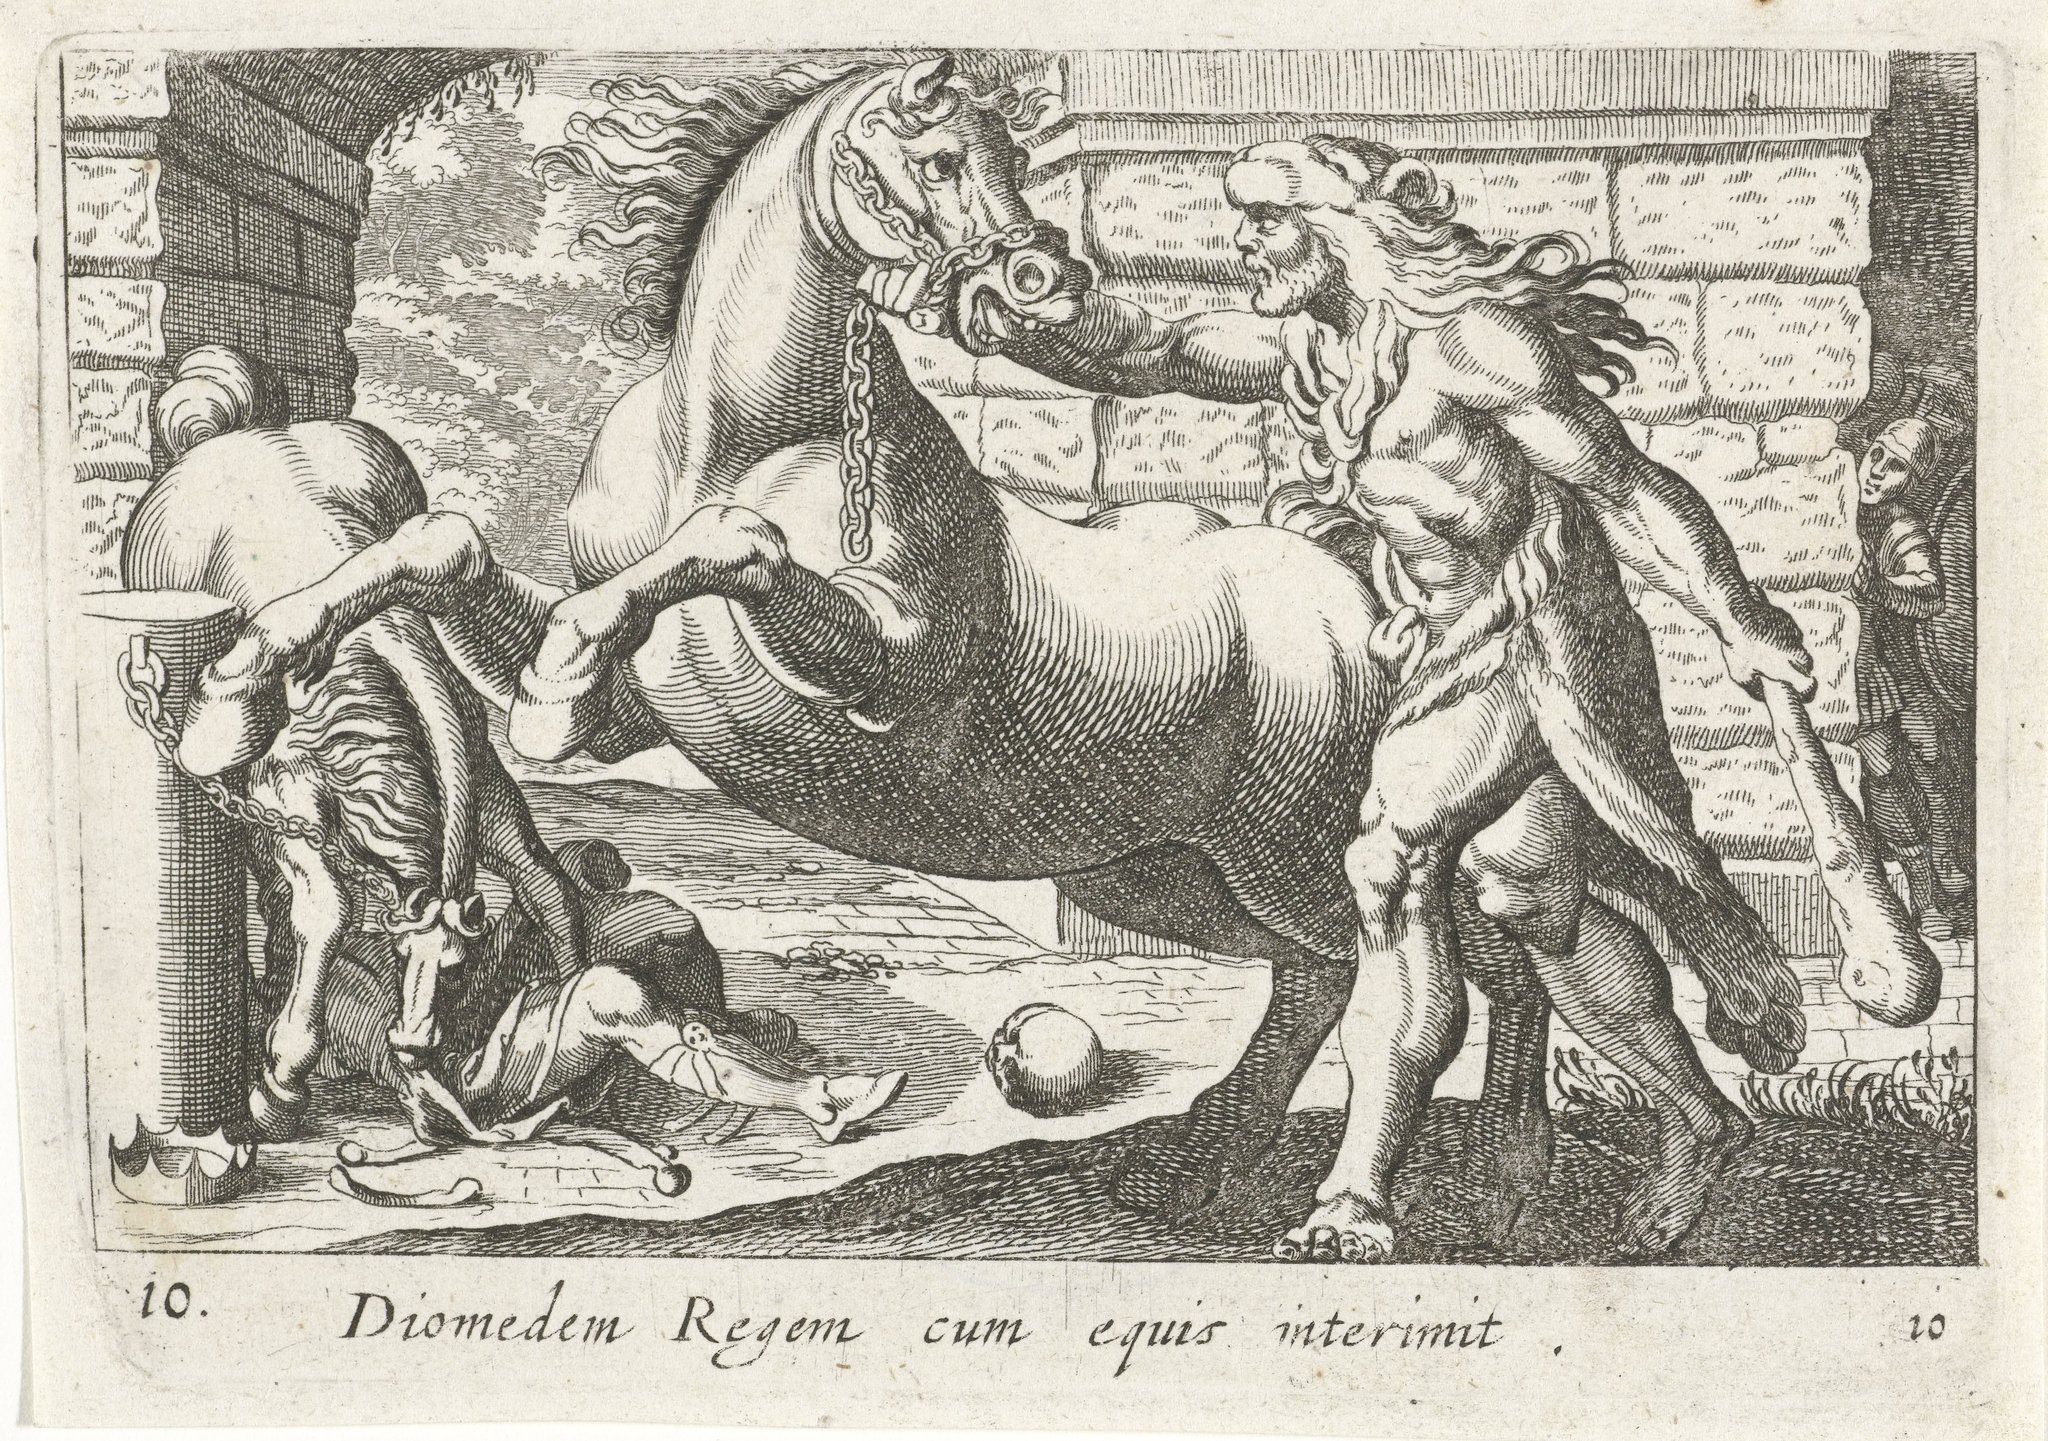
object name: print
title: Herculische thema's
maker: simon frisius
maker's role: print maker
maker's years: 1570-1628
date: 1610-1664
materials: paper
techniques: etching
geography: italy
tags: (8) the four mares of king diomedes are captured; when diomedes is slain in the ensuing battle his body is thrown to the mares to eat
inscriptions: collector's mark: Lugt 2228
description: Rechts temt Hercules een vleesetend paard van Diomedes. Links valt Diomedes ten prooi aan zijn eigen paard.